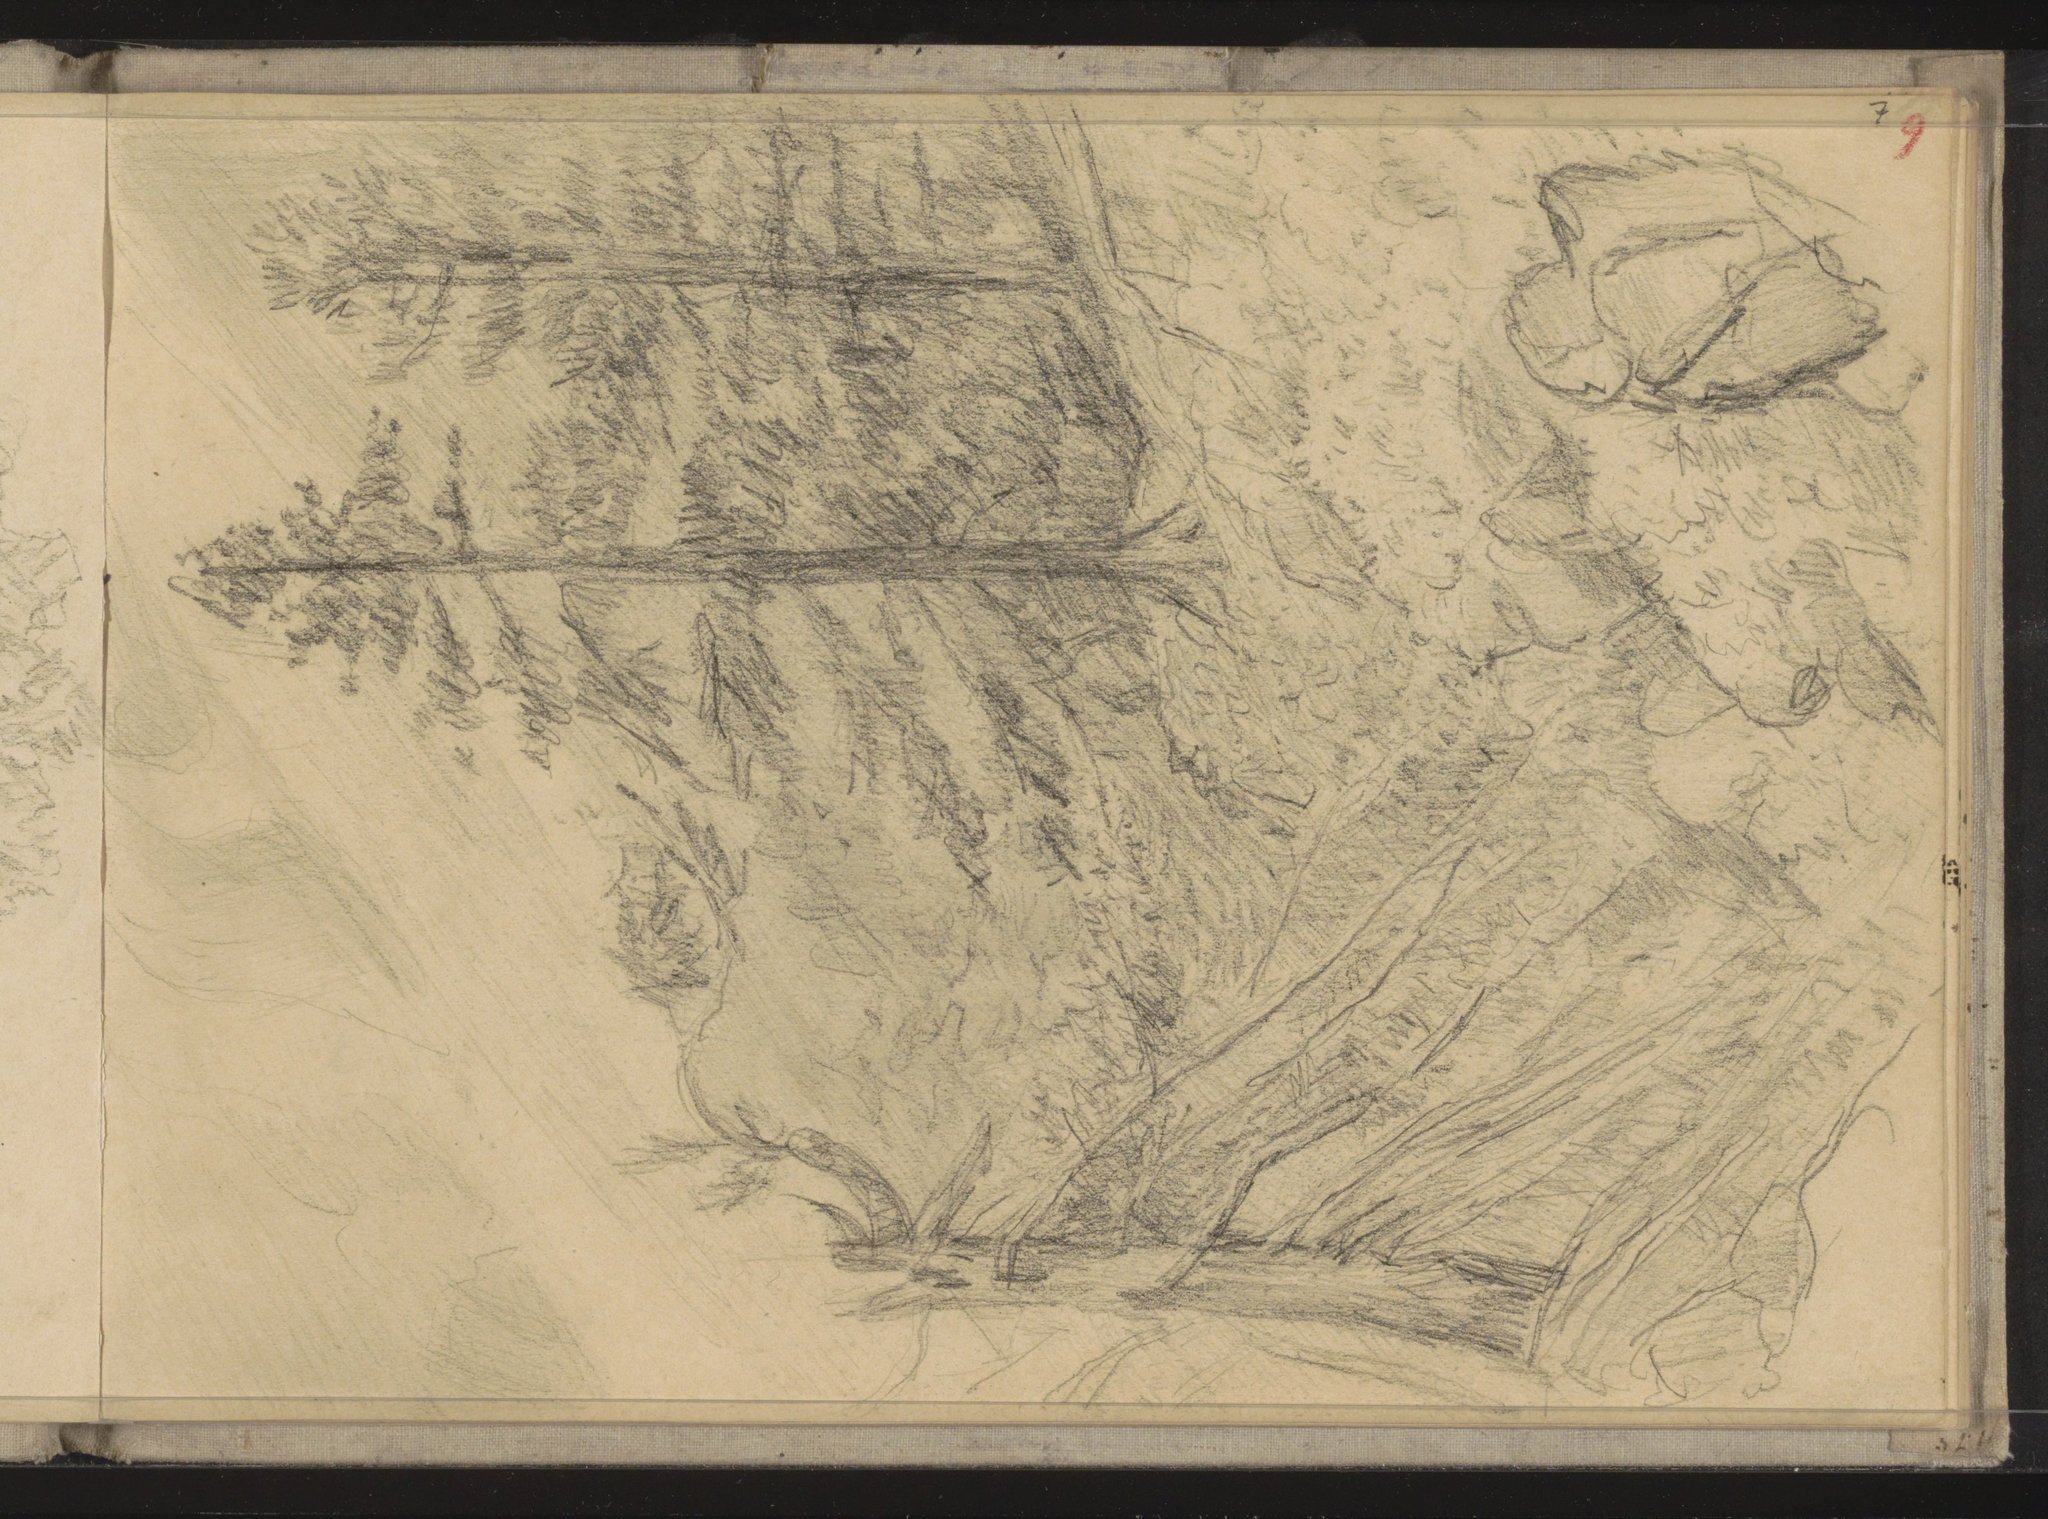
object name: sketchbook leaf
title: Berglandschap met dennen en keien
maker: jozef israëls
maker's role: draughtsman, painter, print maker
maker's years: 1824-1911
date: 1834-1911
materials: paper, pencil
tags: boulder, stone, trees: pine, mountains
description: Blad 7 recto uit een schetsboek met 18 bladen.